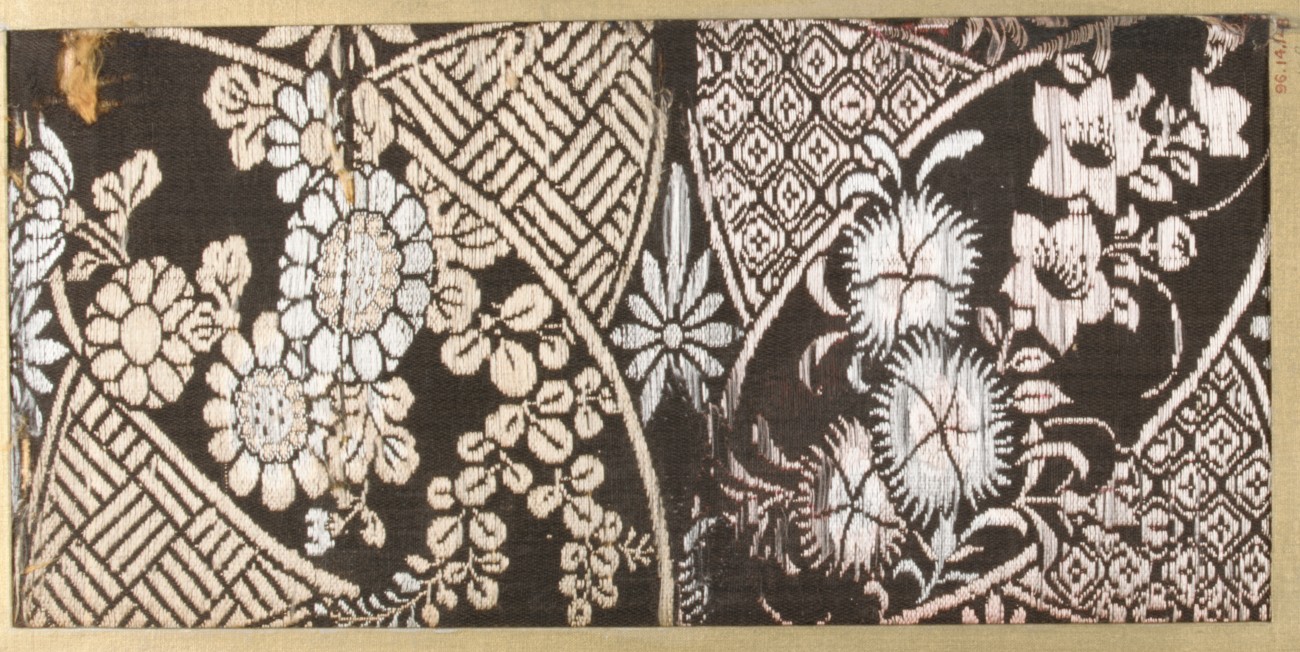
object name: piece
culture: japanese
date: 1701-1900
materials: silk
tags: leaves